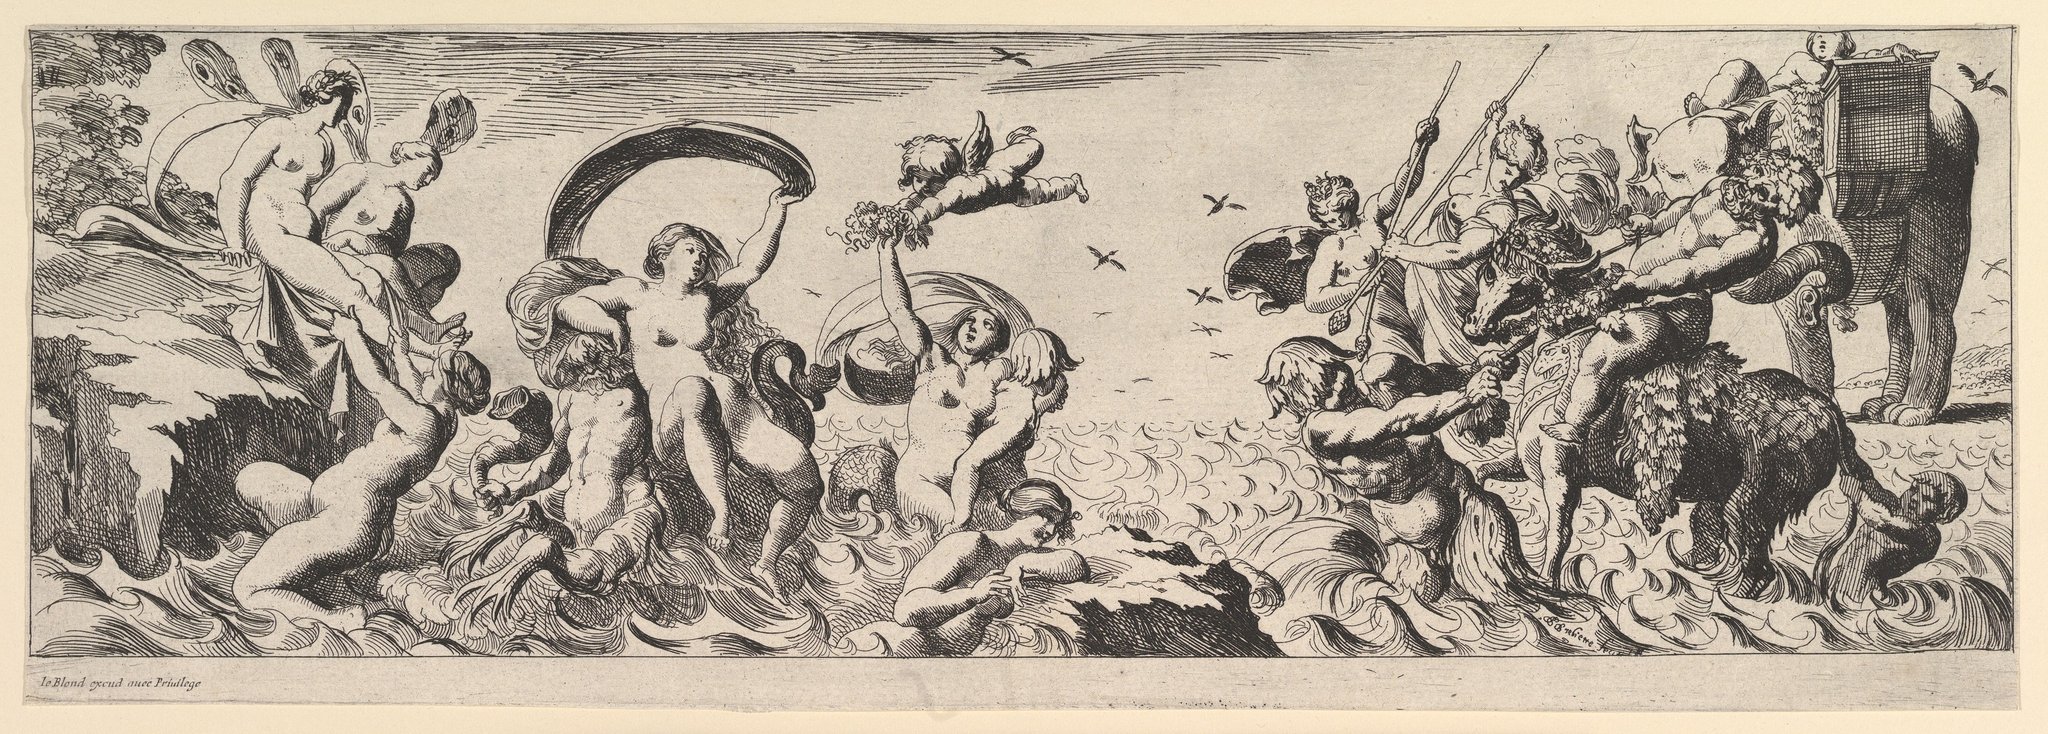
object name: print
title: Bacchanal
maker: pierre brebiette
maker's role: artist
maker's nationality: french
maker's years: 1598-1642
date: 1601-1700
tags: animals,female nudes